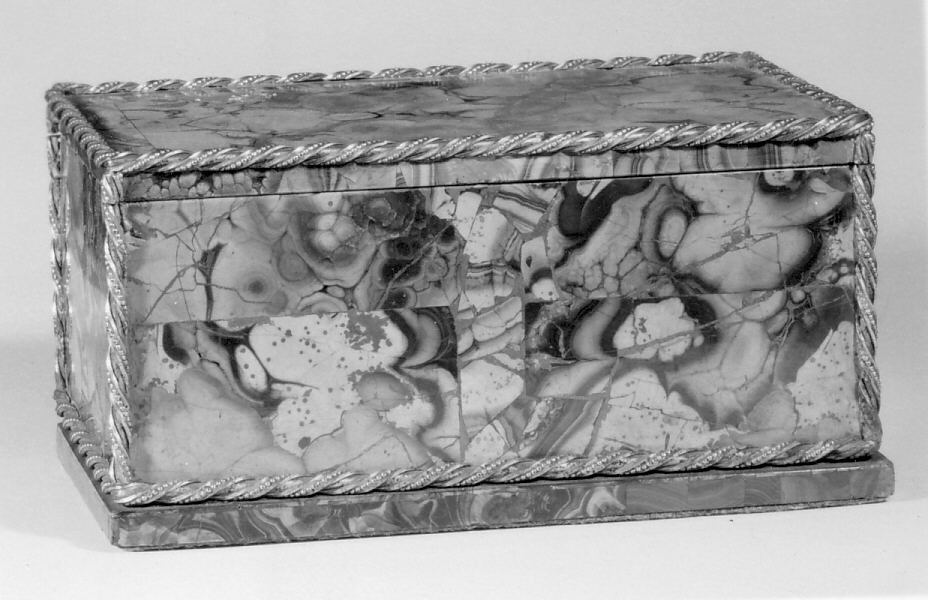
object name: covered box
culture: chinese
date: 1901-2000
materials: wood